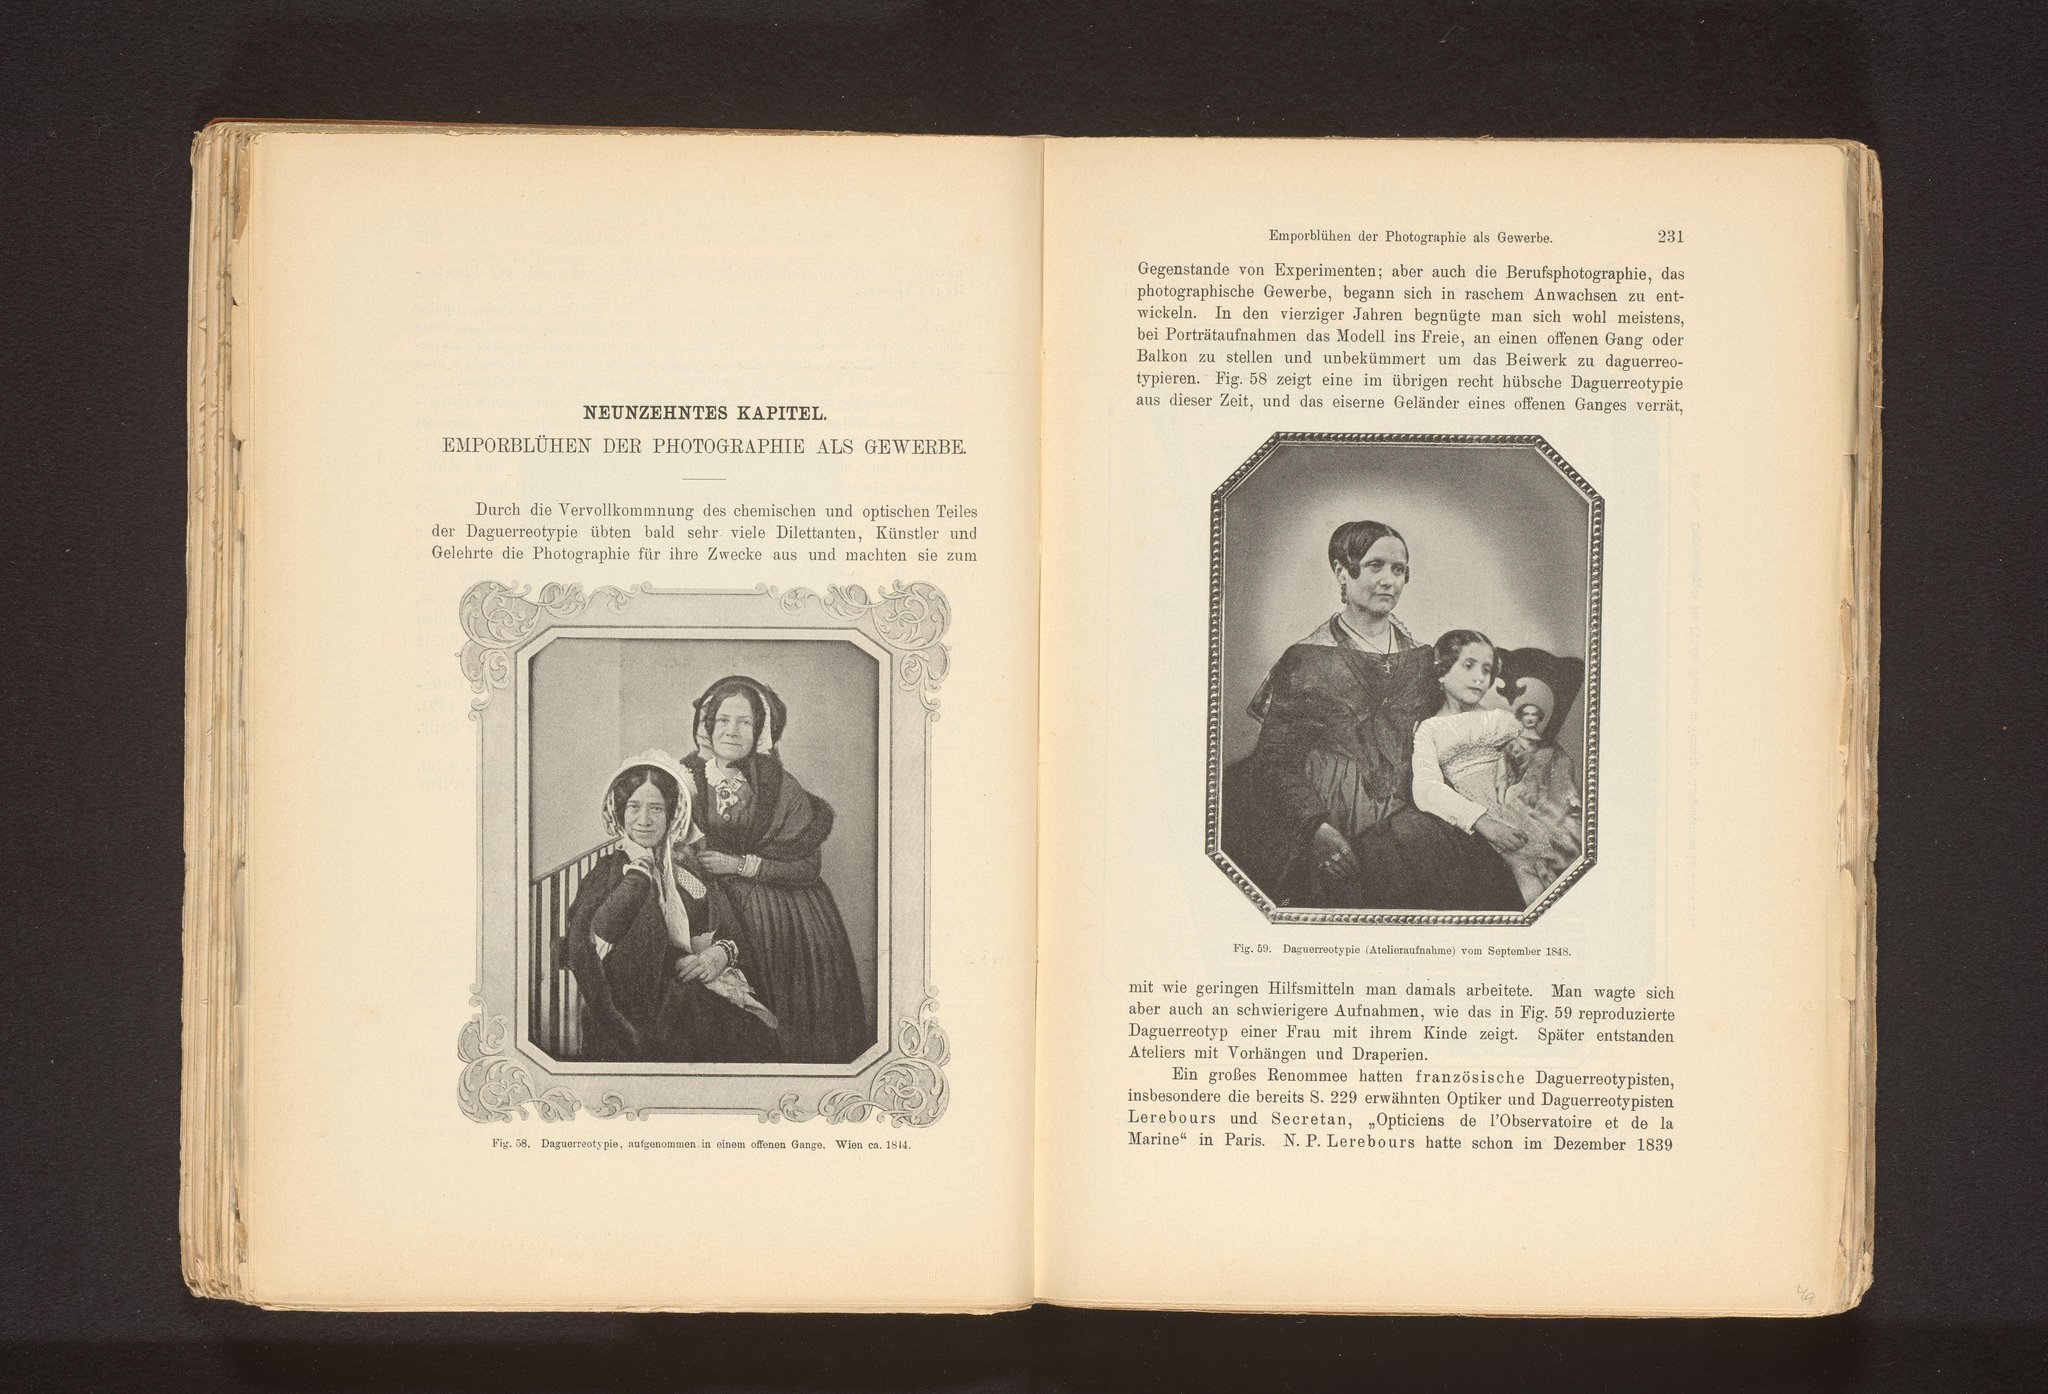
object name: photomechanical print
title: Portret van twee onbekende vrouwen te Wenen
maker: Anonymous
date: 1900-1905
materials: paper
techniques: autotype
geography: vienna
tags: adult woman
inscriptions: number: ‘Fig. 58.’